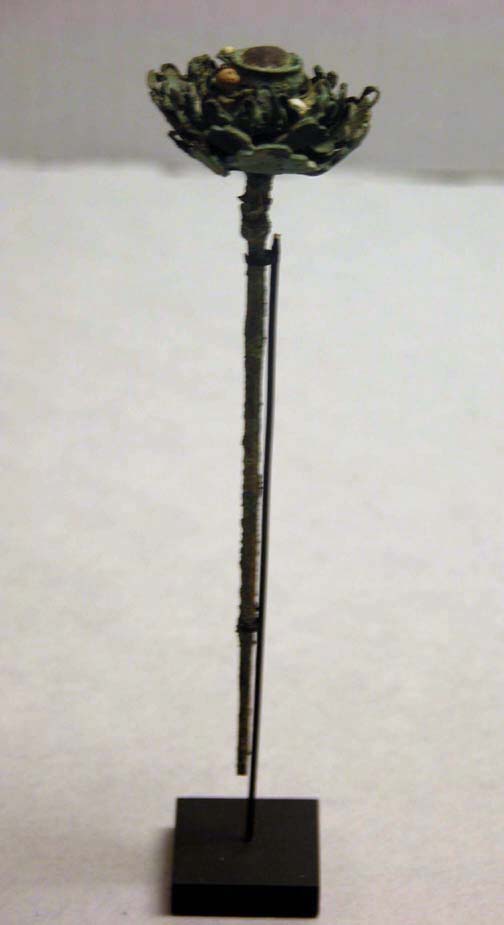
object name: hair ornament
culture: chinese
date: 618-907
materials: silver gilt